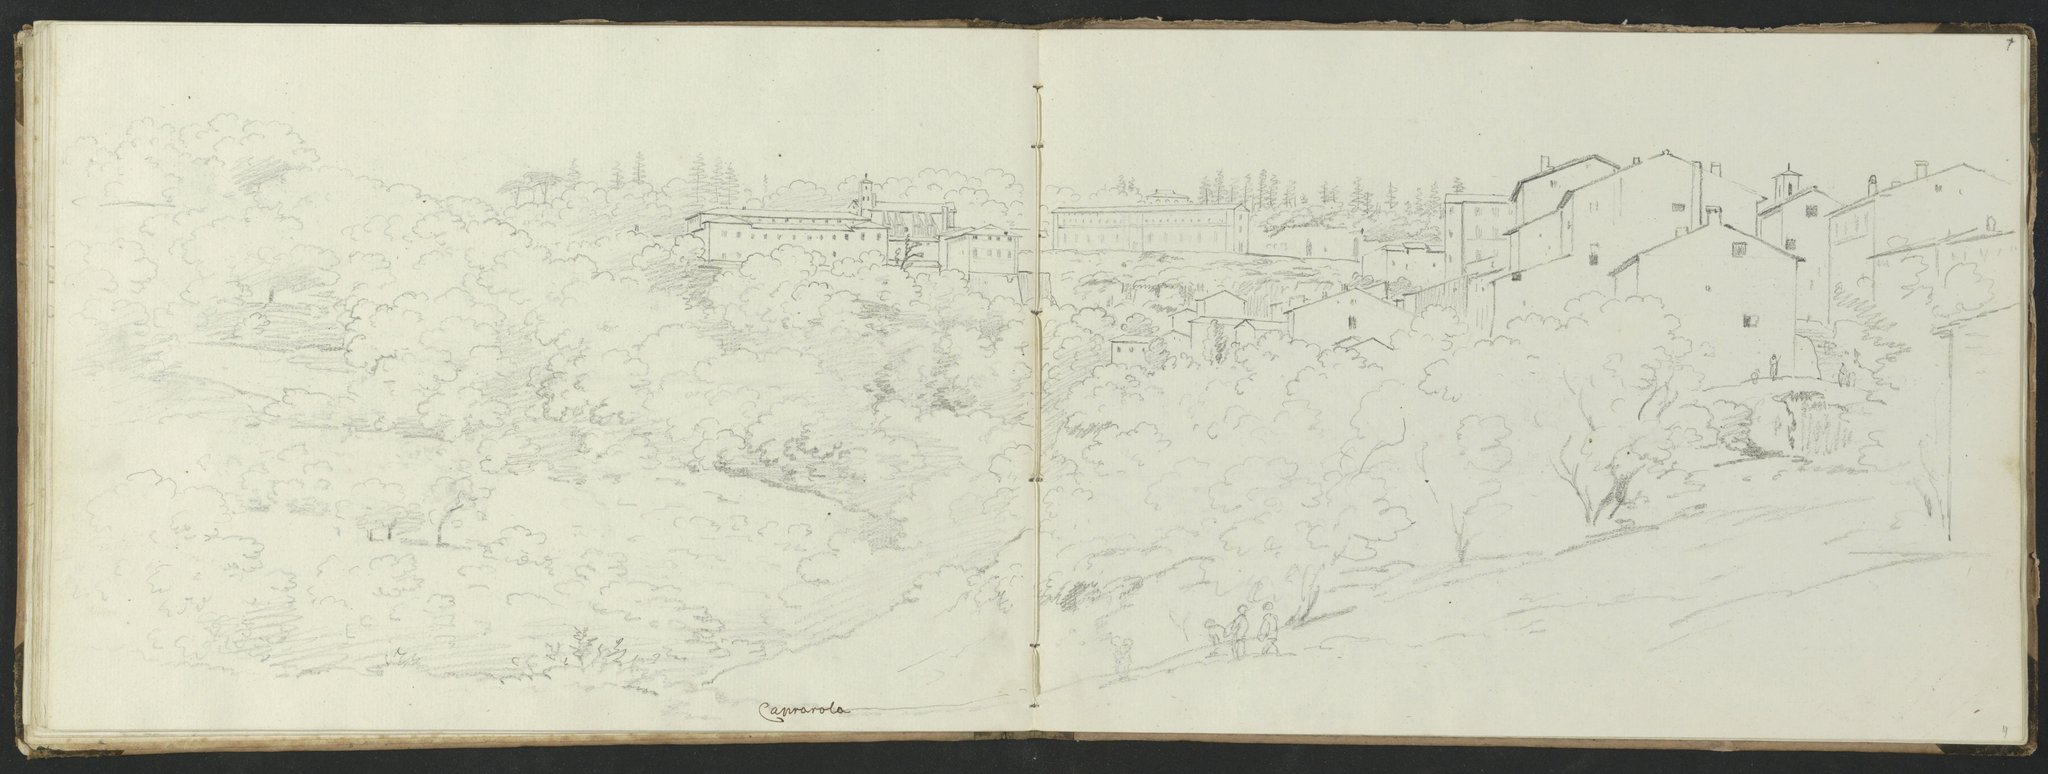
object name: sketchbook leaf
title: Gezicht op Caprarola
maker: abraham teerlink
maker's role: draughtsman, painter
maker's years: 1776-1857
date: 1808-1857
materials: paper, pencil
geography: caprarola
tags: city-view, and landscape with man-made constructions, mountains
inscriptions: annotation: ‘Caprarola’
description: Op de voorgrond wandelaars op een pad. Blad 18 verso en 19 recto uit een schetsboek met 28 bladen.